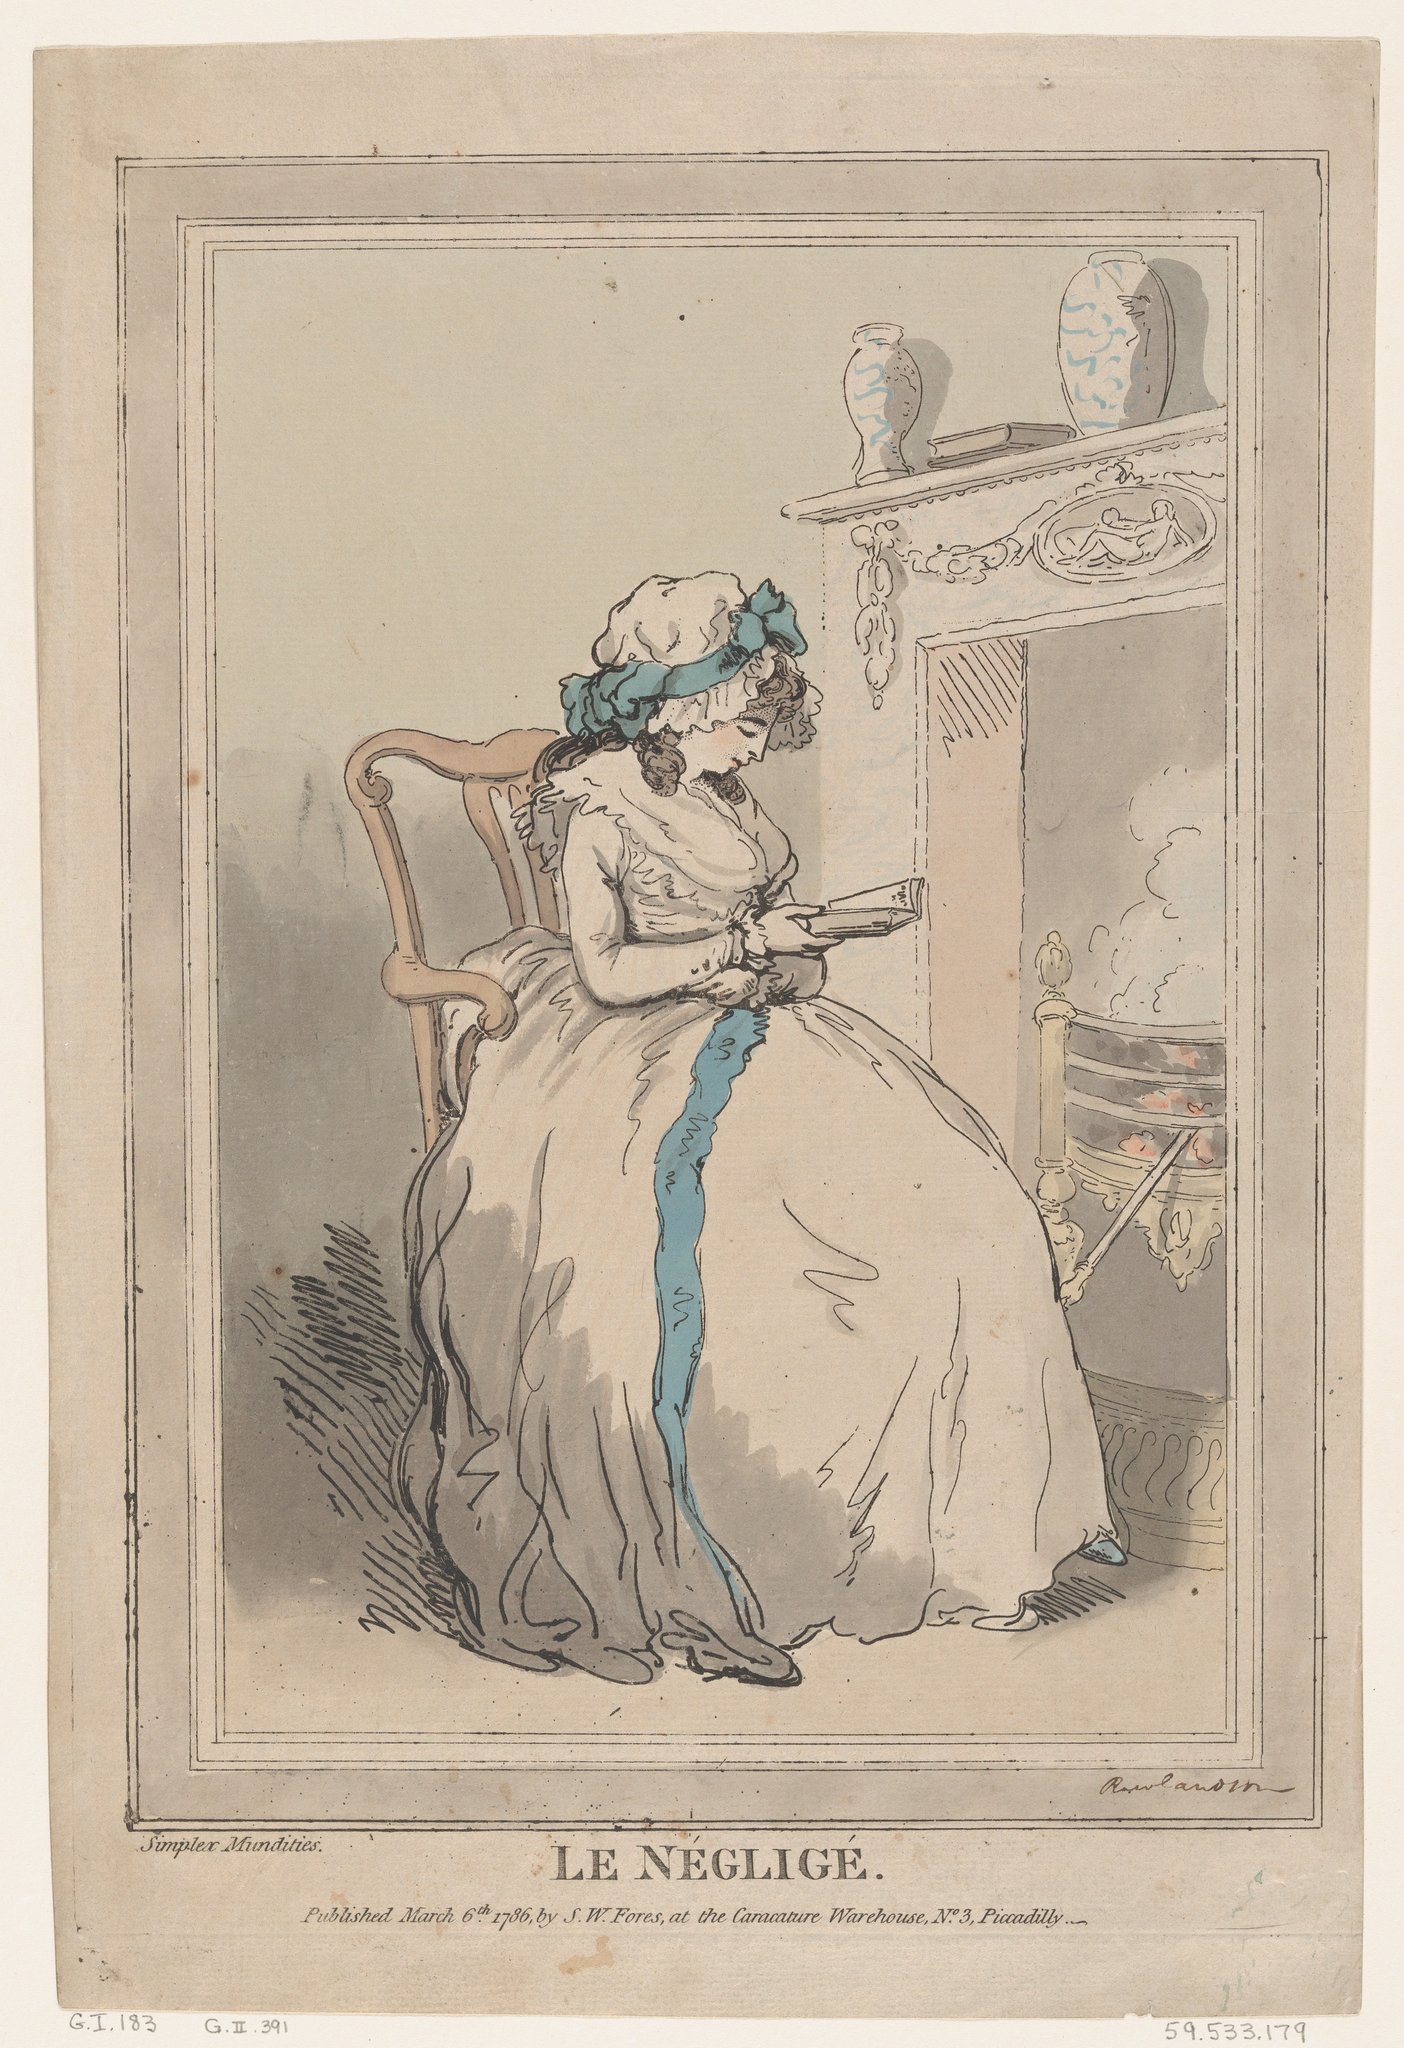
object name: print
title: Le Négligé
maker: thomas rowlandson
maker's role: artist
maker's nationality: british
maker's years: 1757-1827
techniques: etching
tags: profiles,women,reading